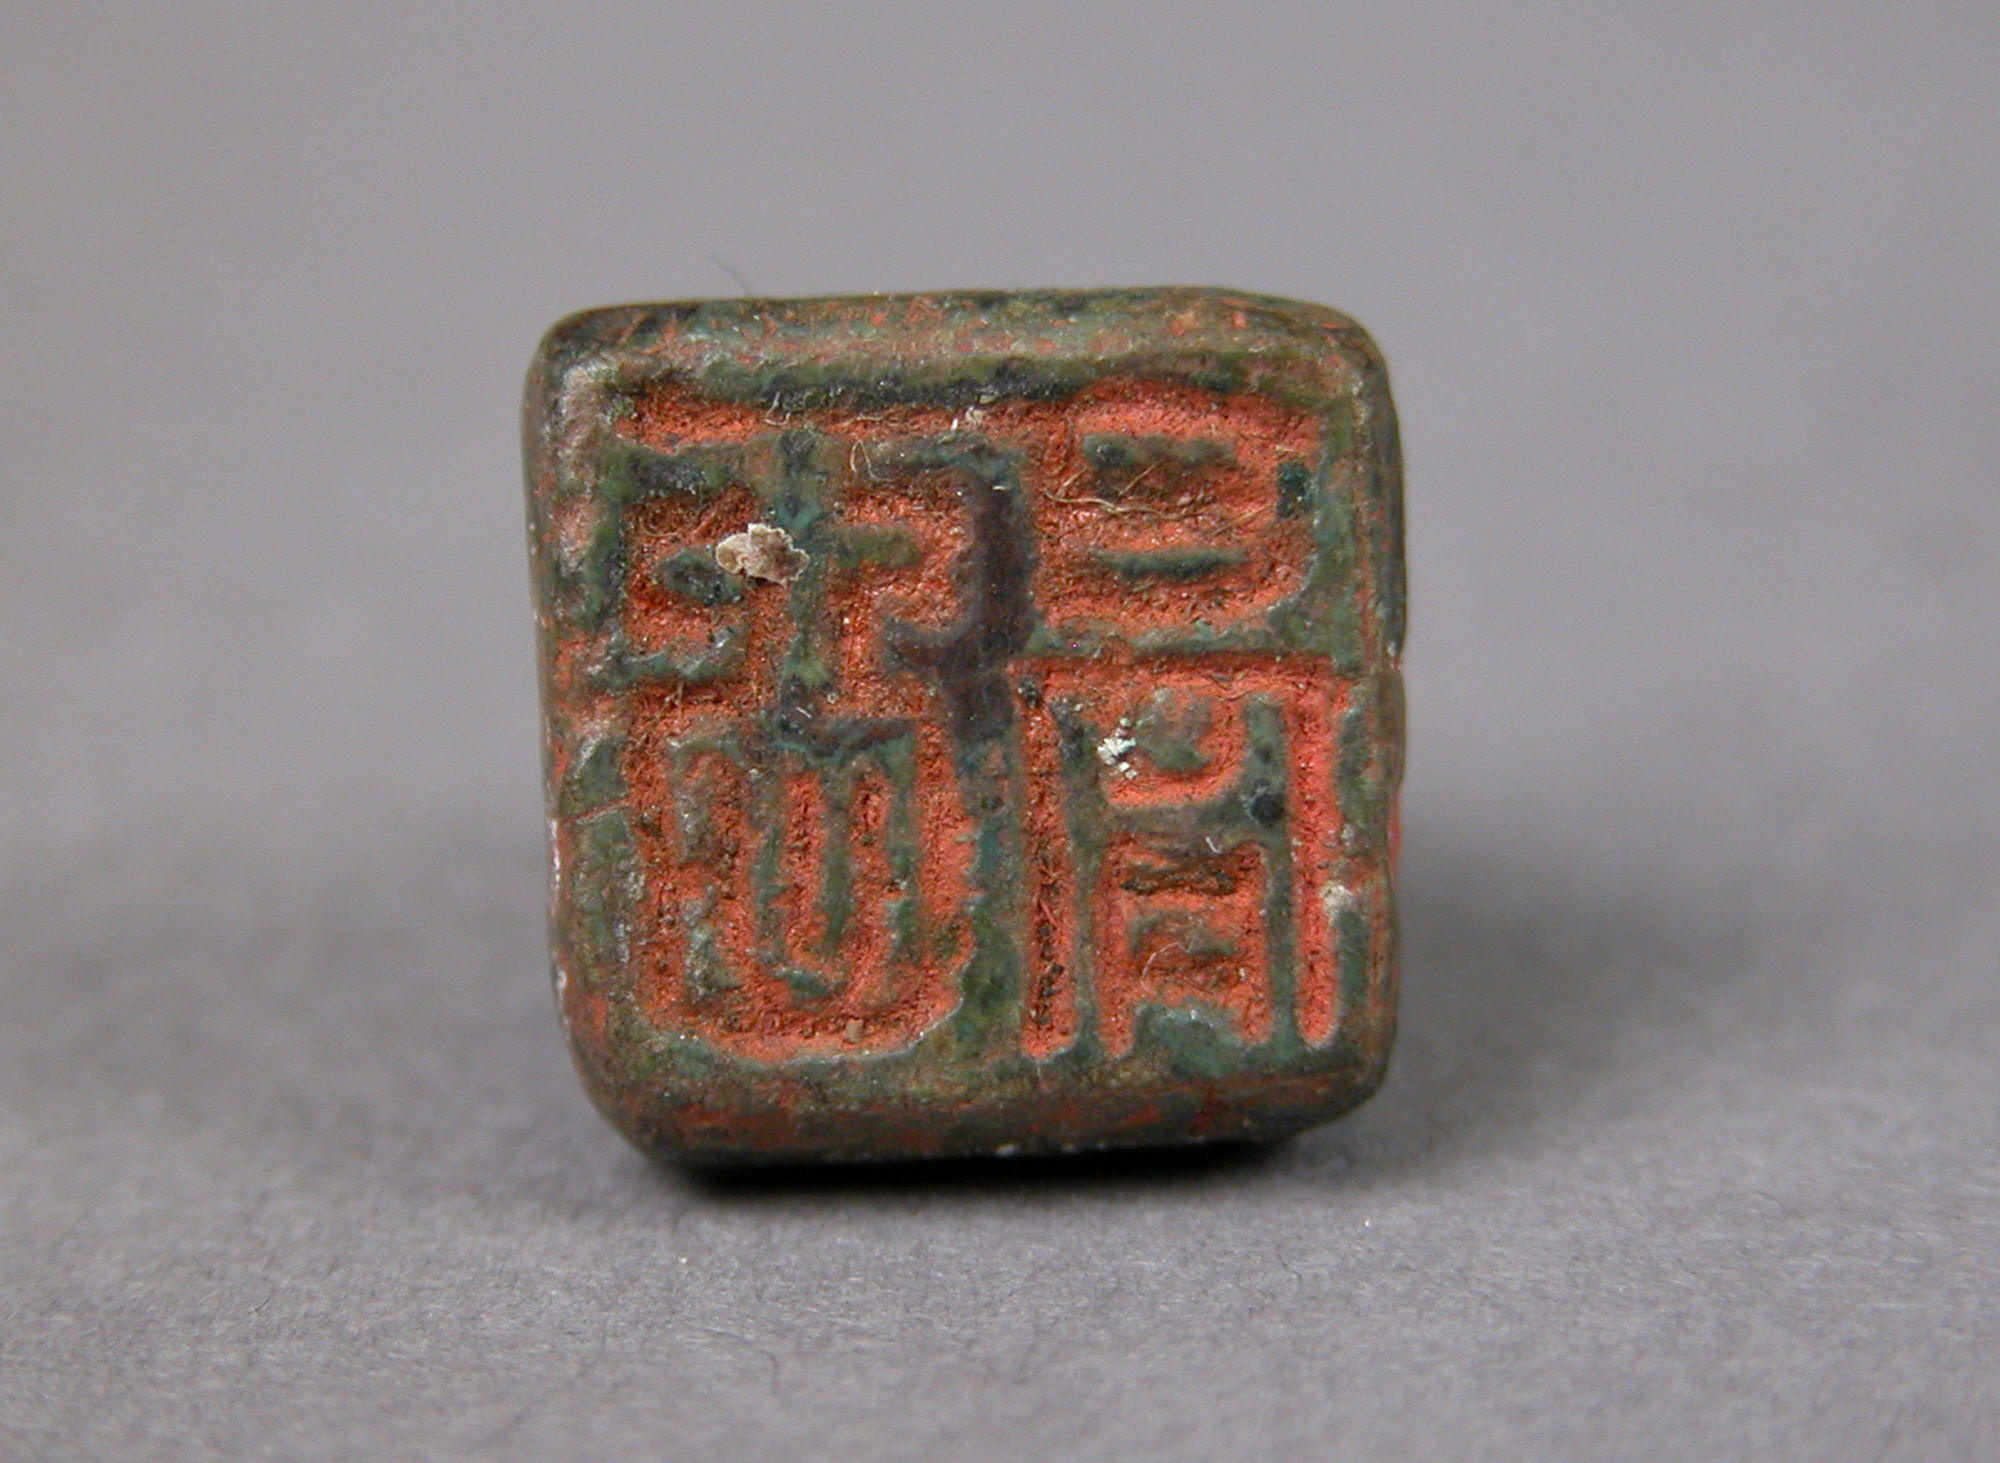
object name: seal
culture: chinese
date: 1300-1644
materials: bronze